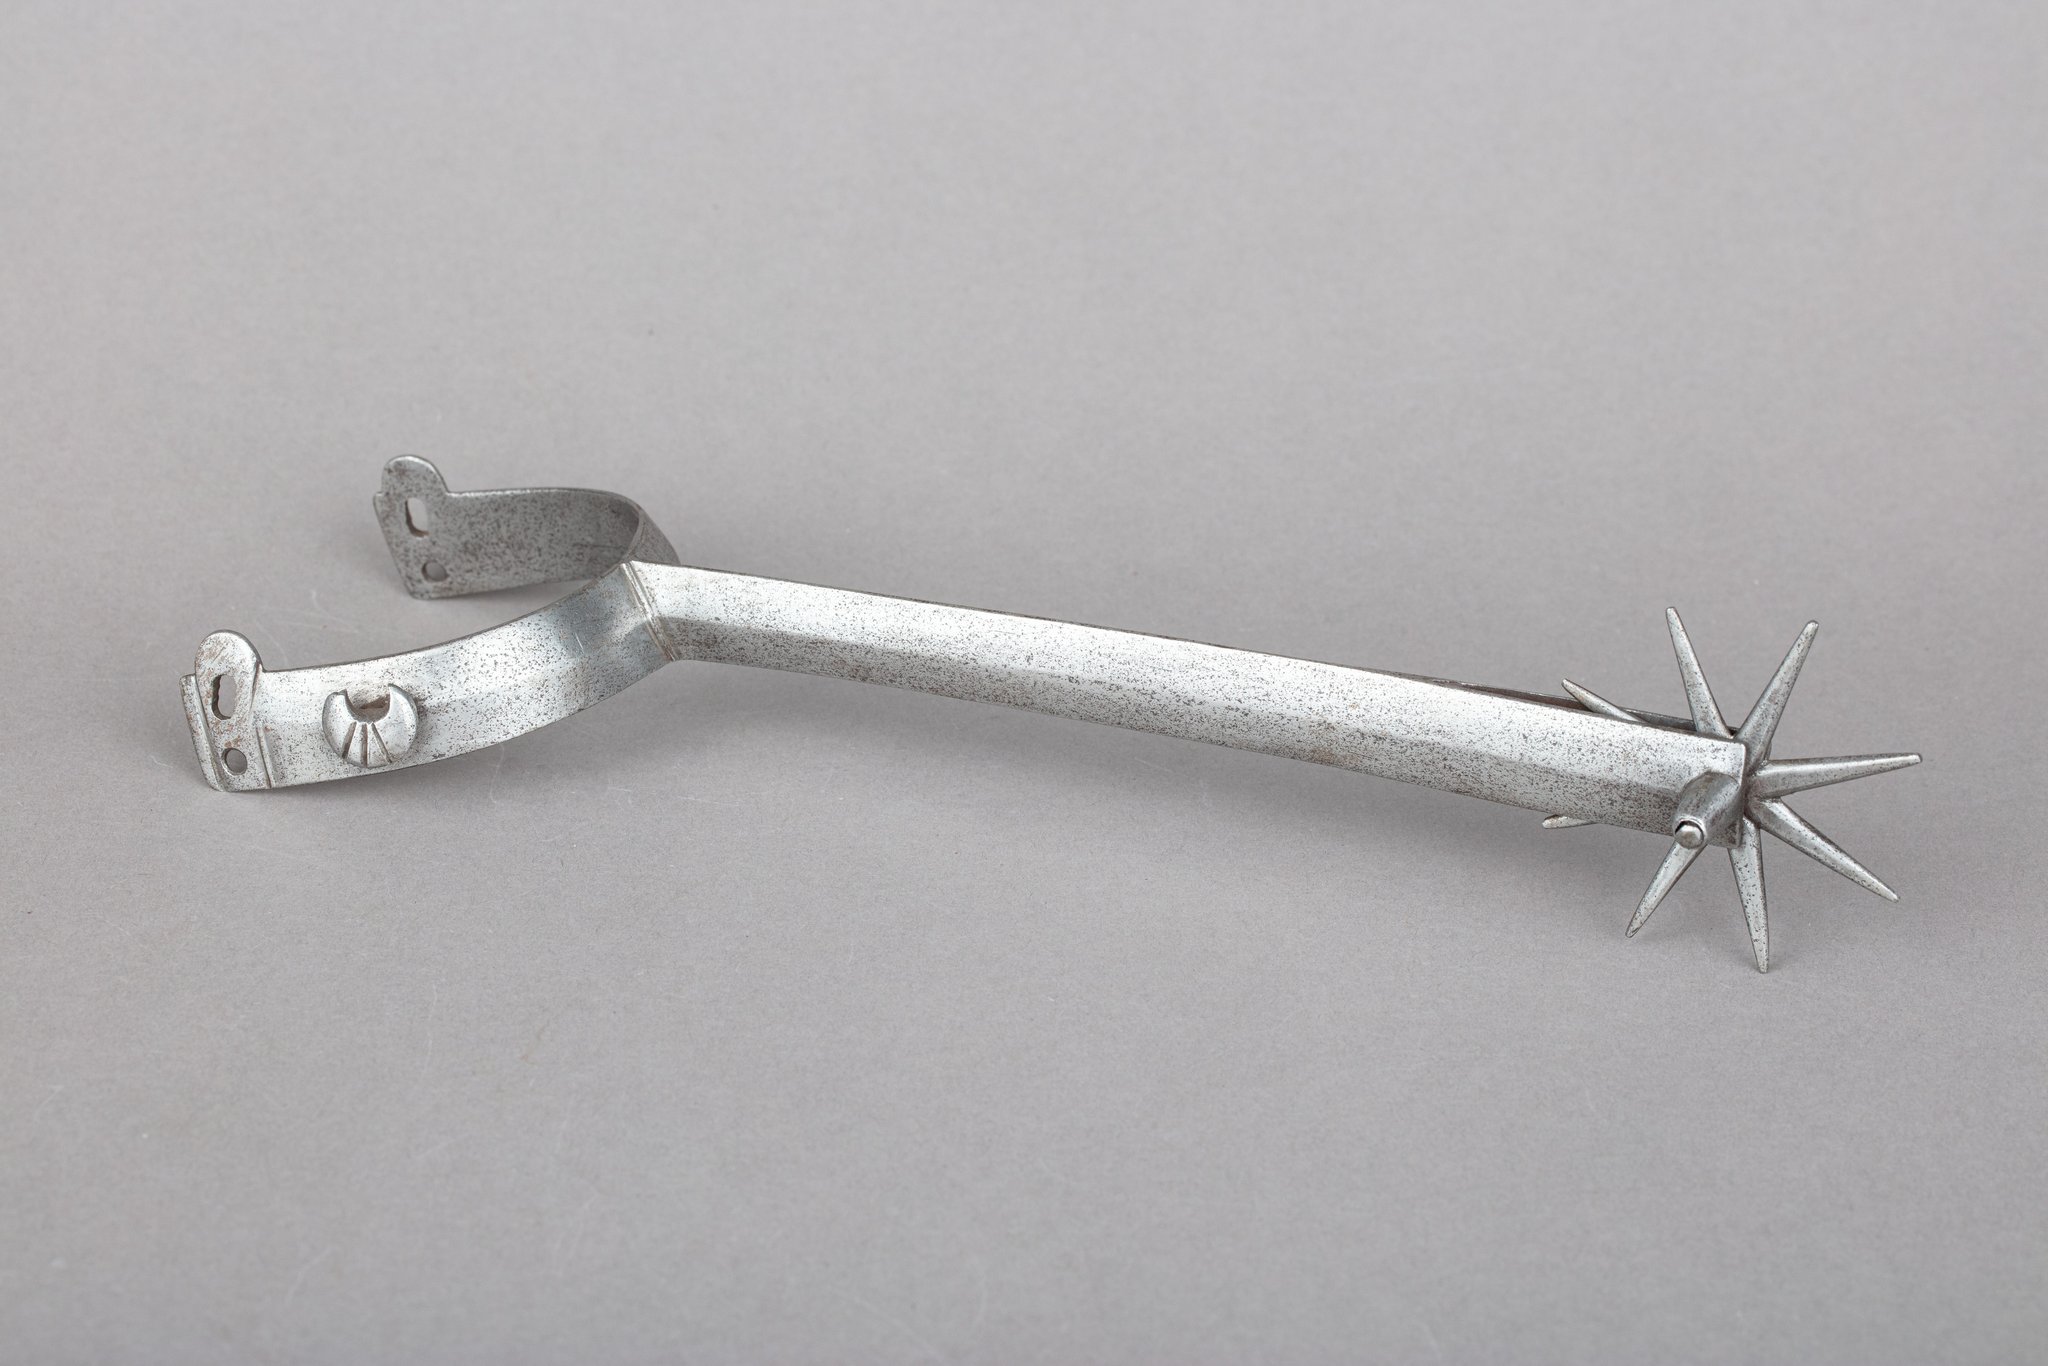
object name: rowel spur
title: Rowel Spur (Left), in the Style of the 15th Century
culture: hungarian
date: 1801-1900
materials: metal alloy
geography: hungary